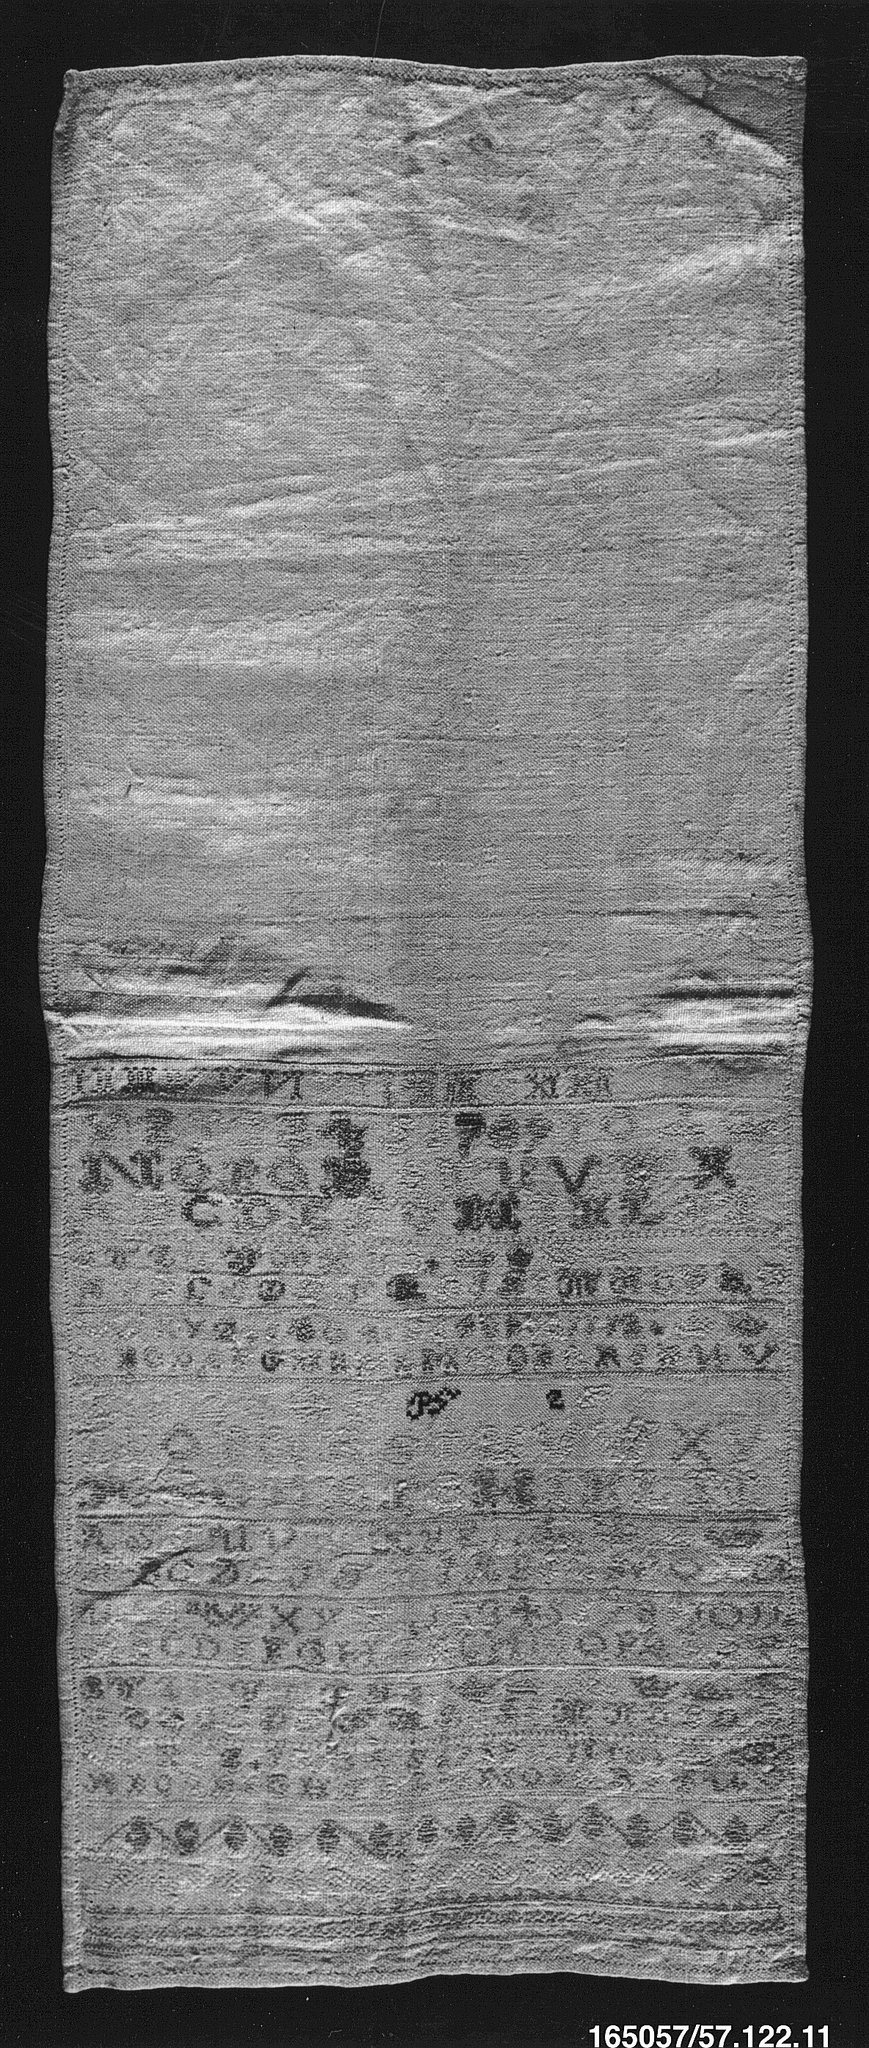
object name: sampler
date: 1701-1800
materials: linen, silk